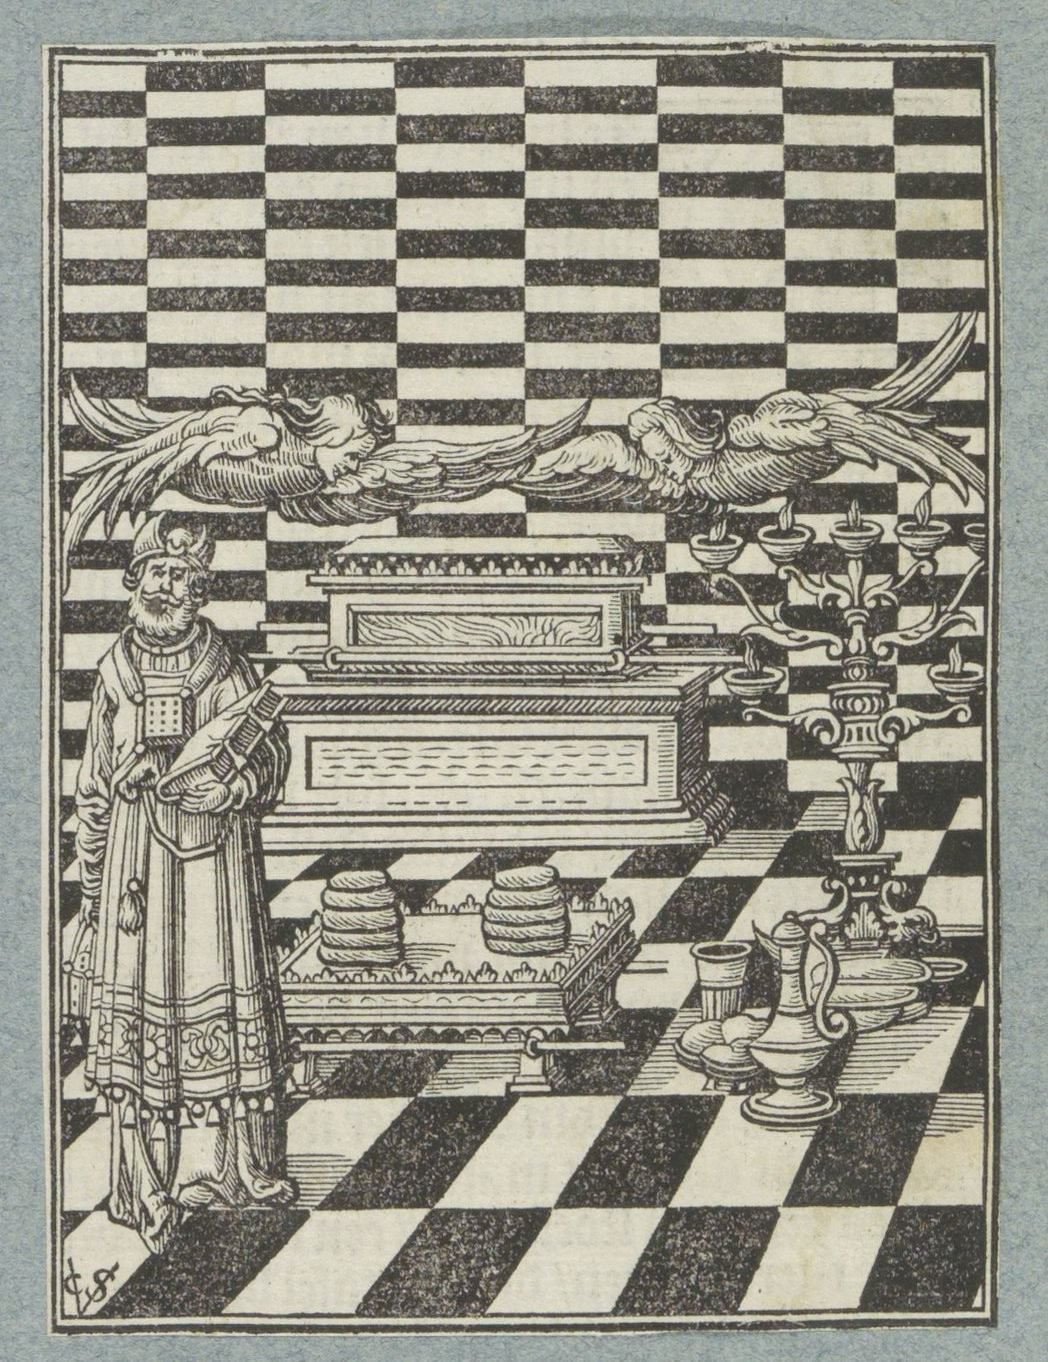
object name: print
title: Ark van het verbond en voorwerpen uit de tabernakel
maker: pieter jacobsz. paets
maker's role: publisher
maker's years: 1587-1667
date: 1645-1646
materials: paper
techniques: letterpress printing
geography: amsterdam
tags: other objects kept in the tabernacle, ark of the covenant ~ jewish religion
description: Ark van het verbond, waarin tafelen der wet worden bewaard. Daarboven twee cherubijnen. Rechts staat een menora. Daarbij vaatwerk voor de wijnoffers en een tafel met het toonbrood. Links Aäron in priestergewaad. De prent maakt deel uit van een album.